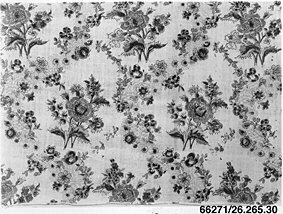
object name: floral print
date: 1767-1800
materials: linen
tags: flowers,leaves